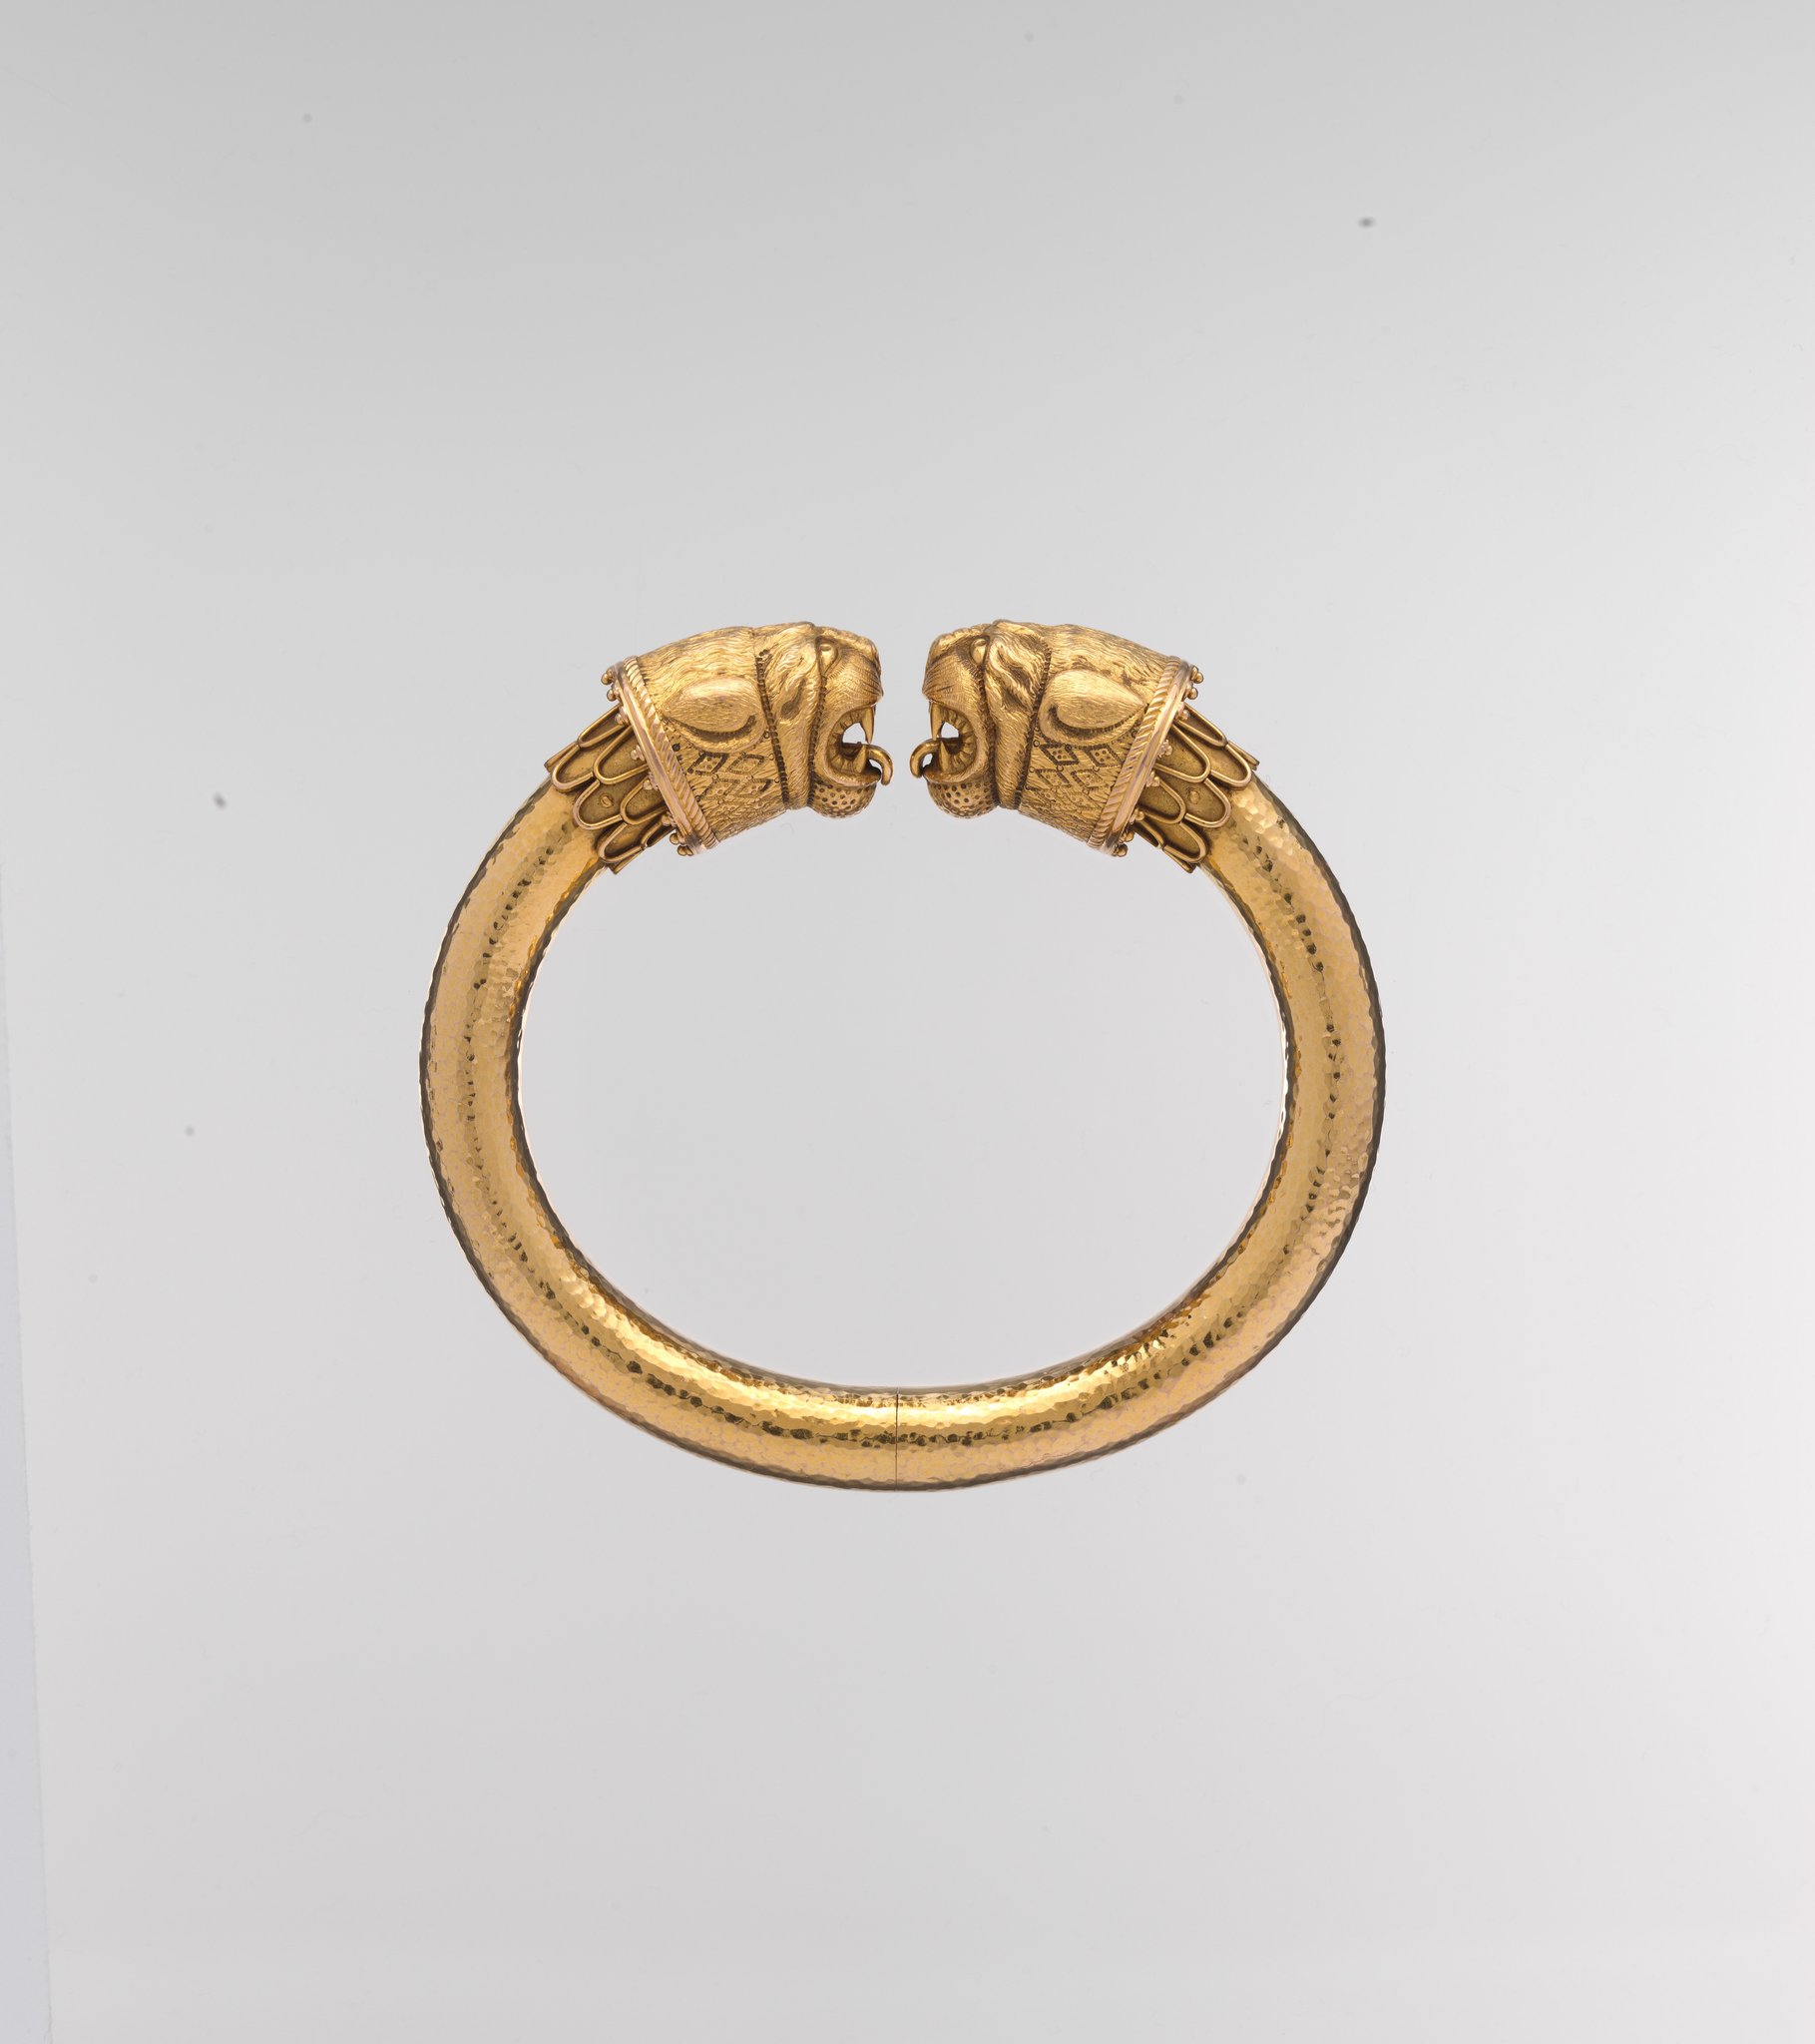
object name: bracelet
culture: american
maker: tiffany & co.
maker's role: manufacturer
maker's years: 1837-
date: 1878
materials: gold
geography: united states